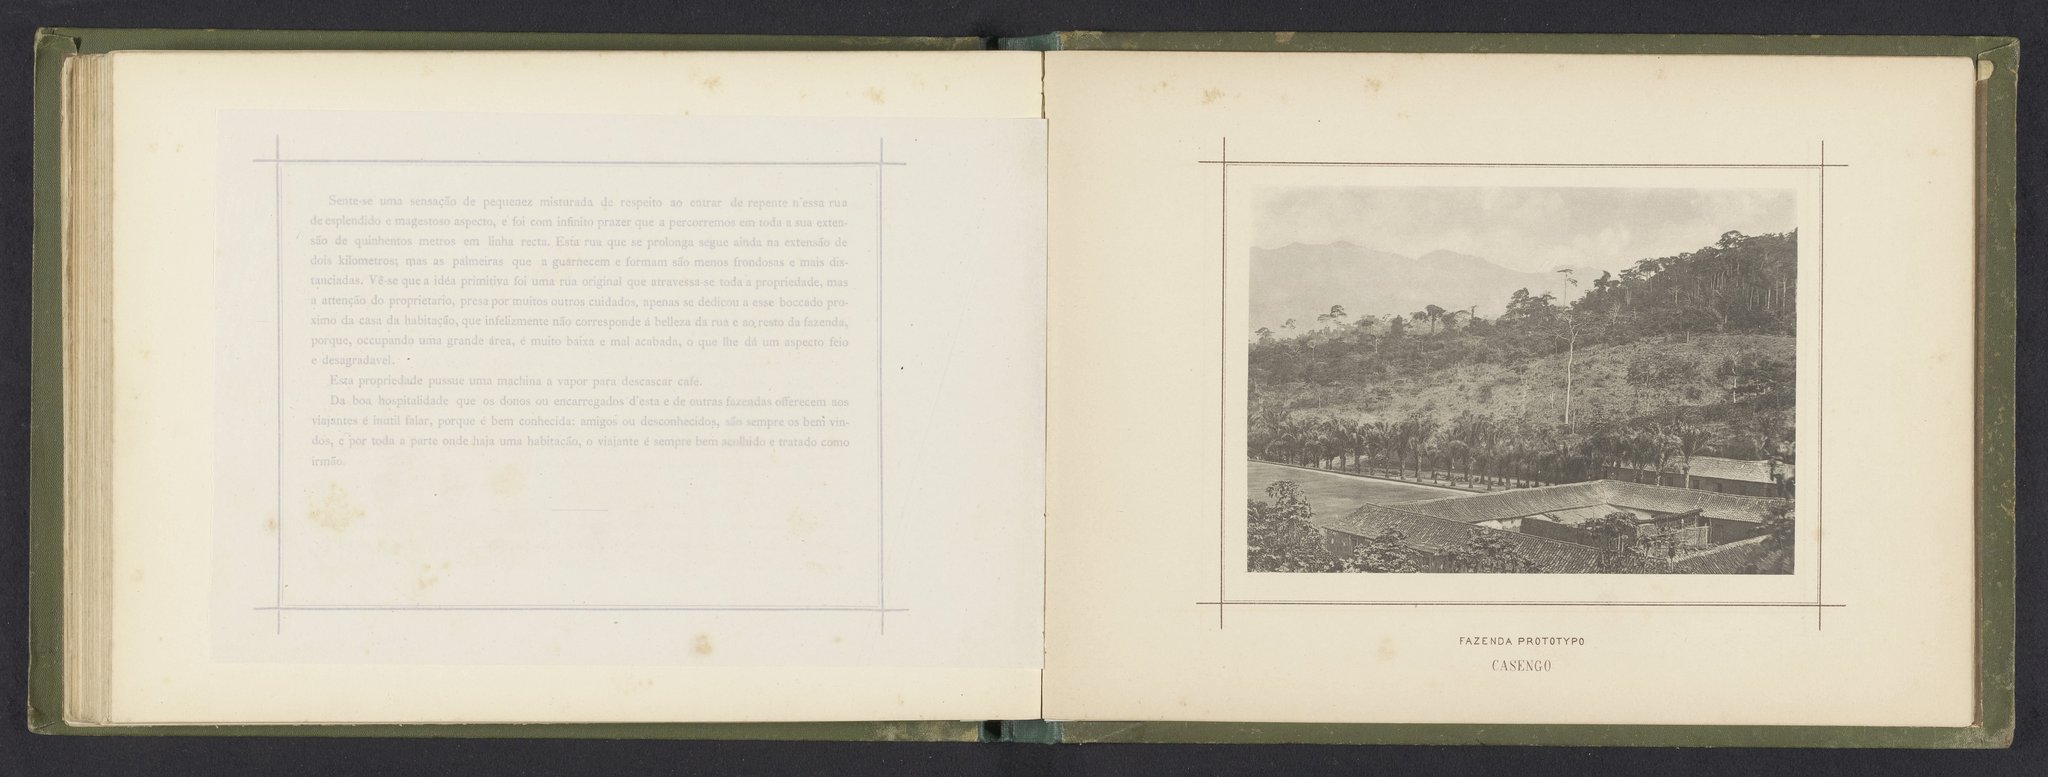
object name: page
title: Gezicht op een boerderij te Angola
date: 1876-1886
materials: paper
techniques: photograph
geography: angola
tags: façade (of house or building), farm (building)